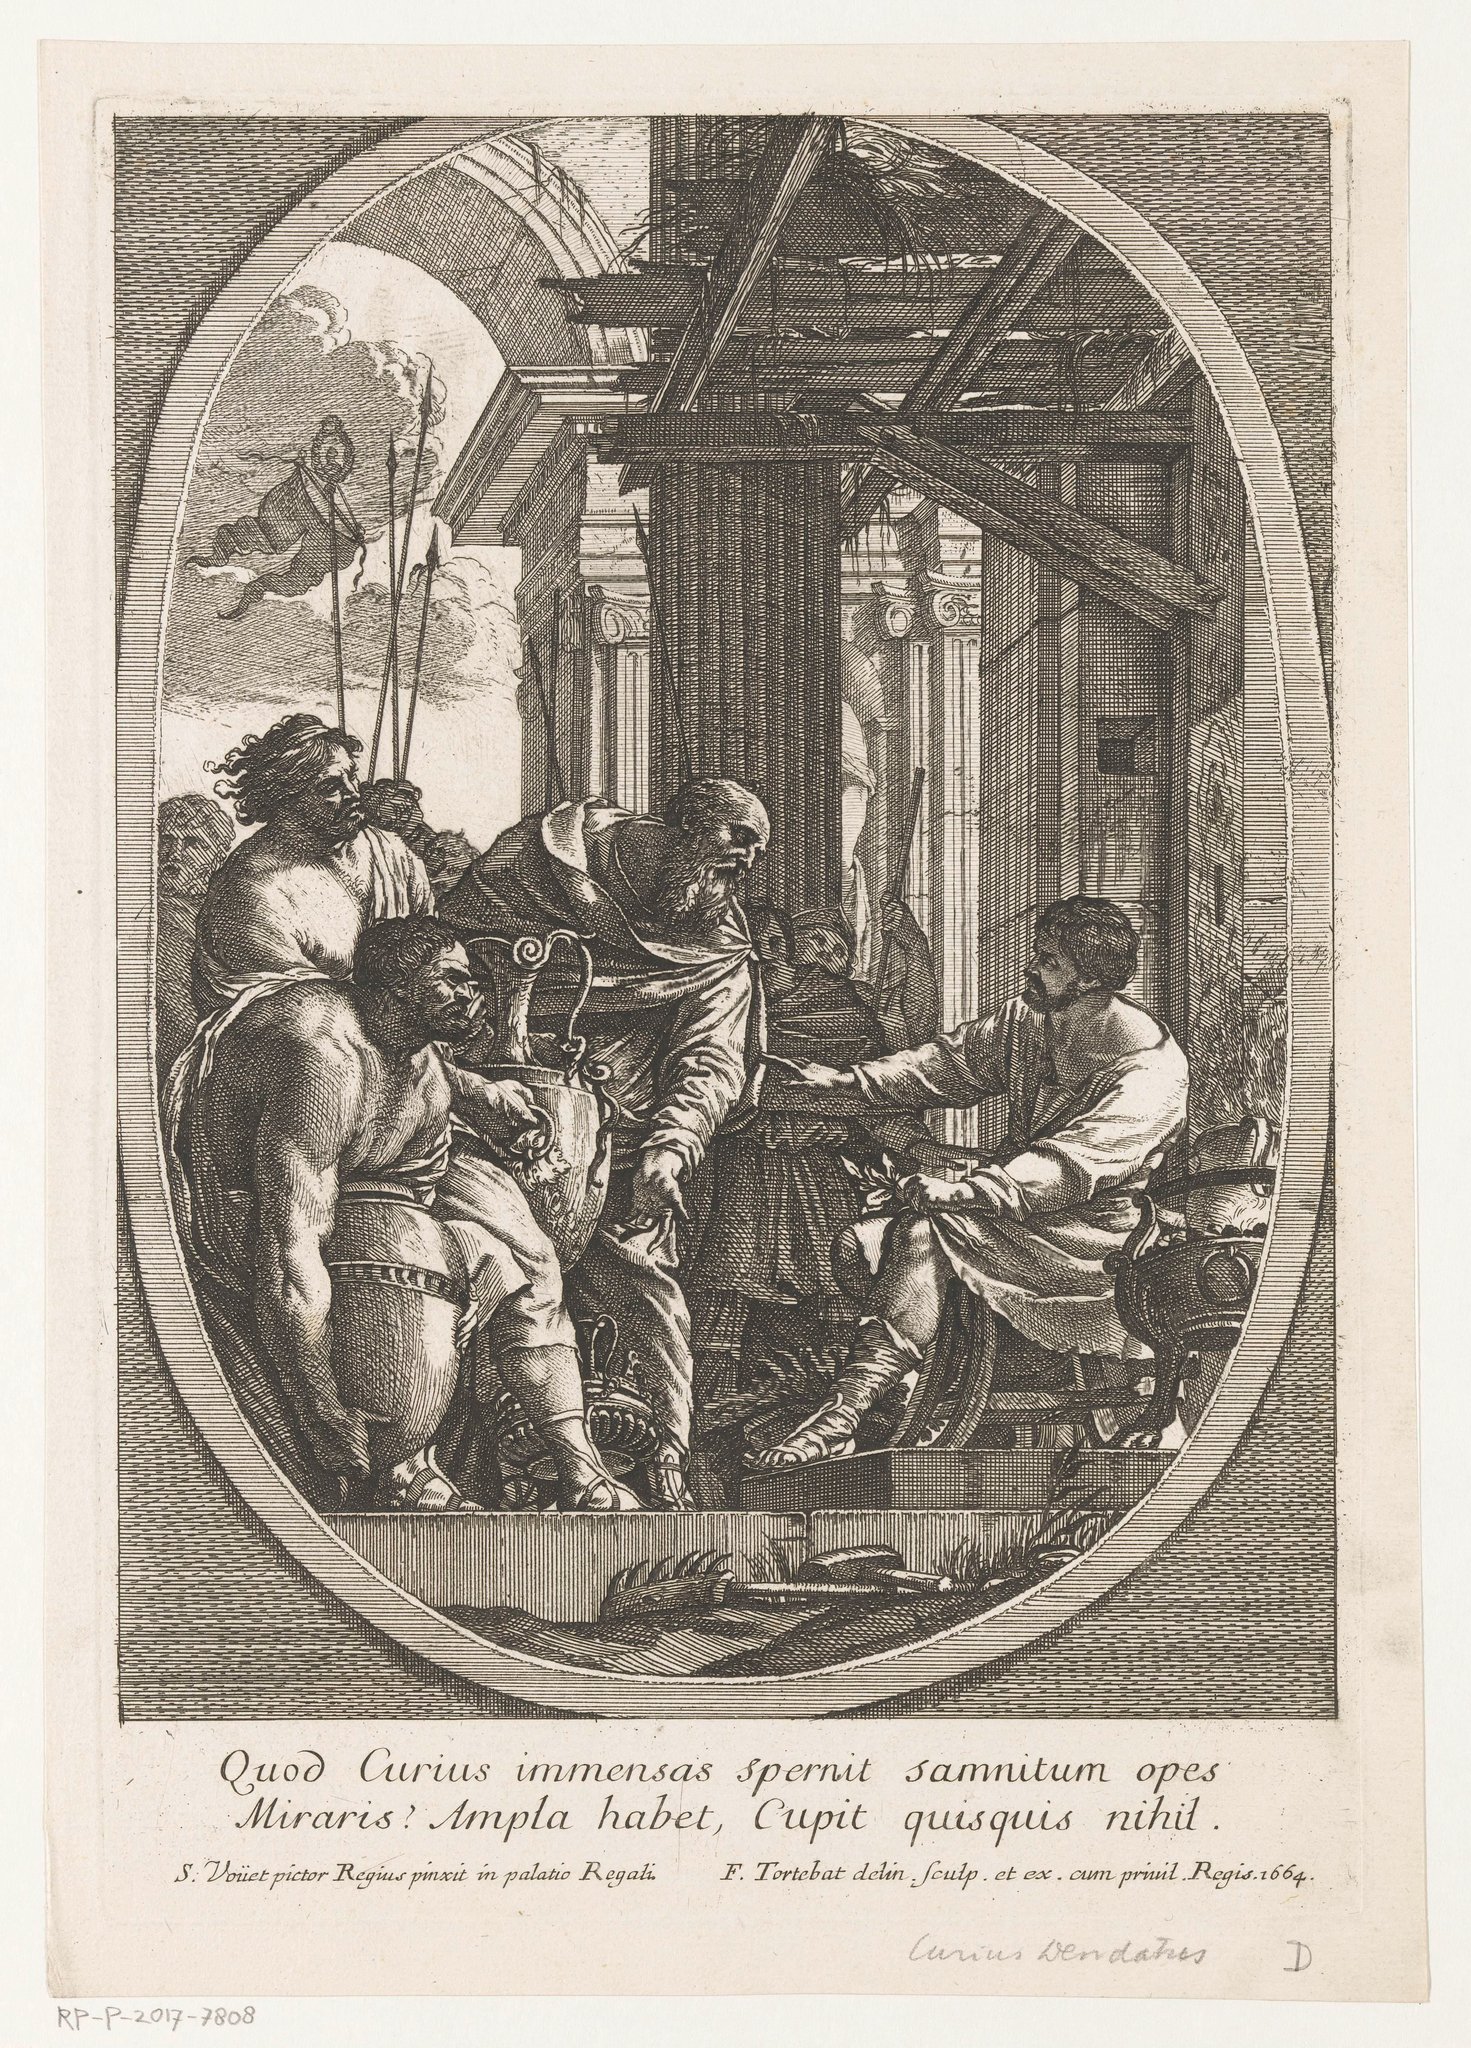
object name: print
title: Manius Curius Dentatus weigert de geschenken van de Samnieten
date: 1664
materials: paper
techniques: engraving, etching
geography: paris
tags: manius curius dentatus, while cooking a simple meal at his hearth, refuses the gifts of the samnites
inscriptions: collector's mark: Lugt 2228